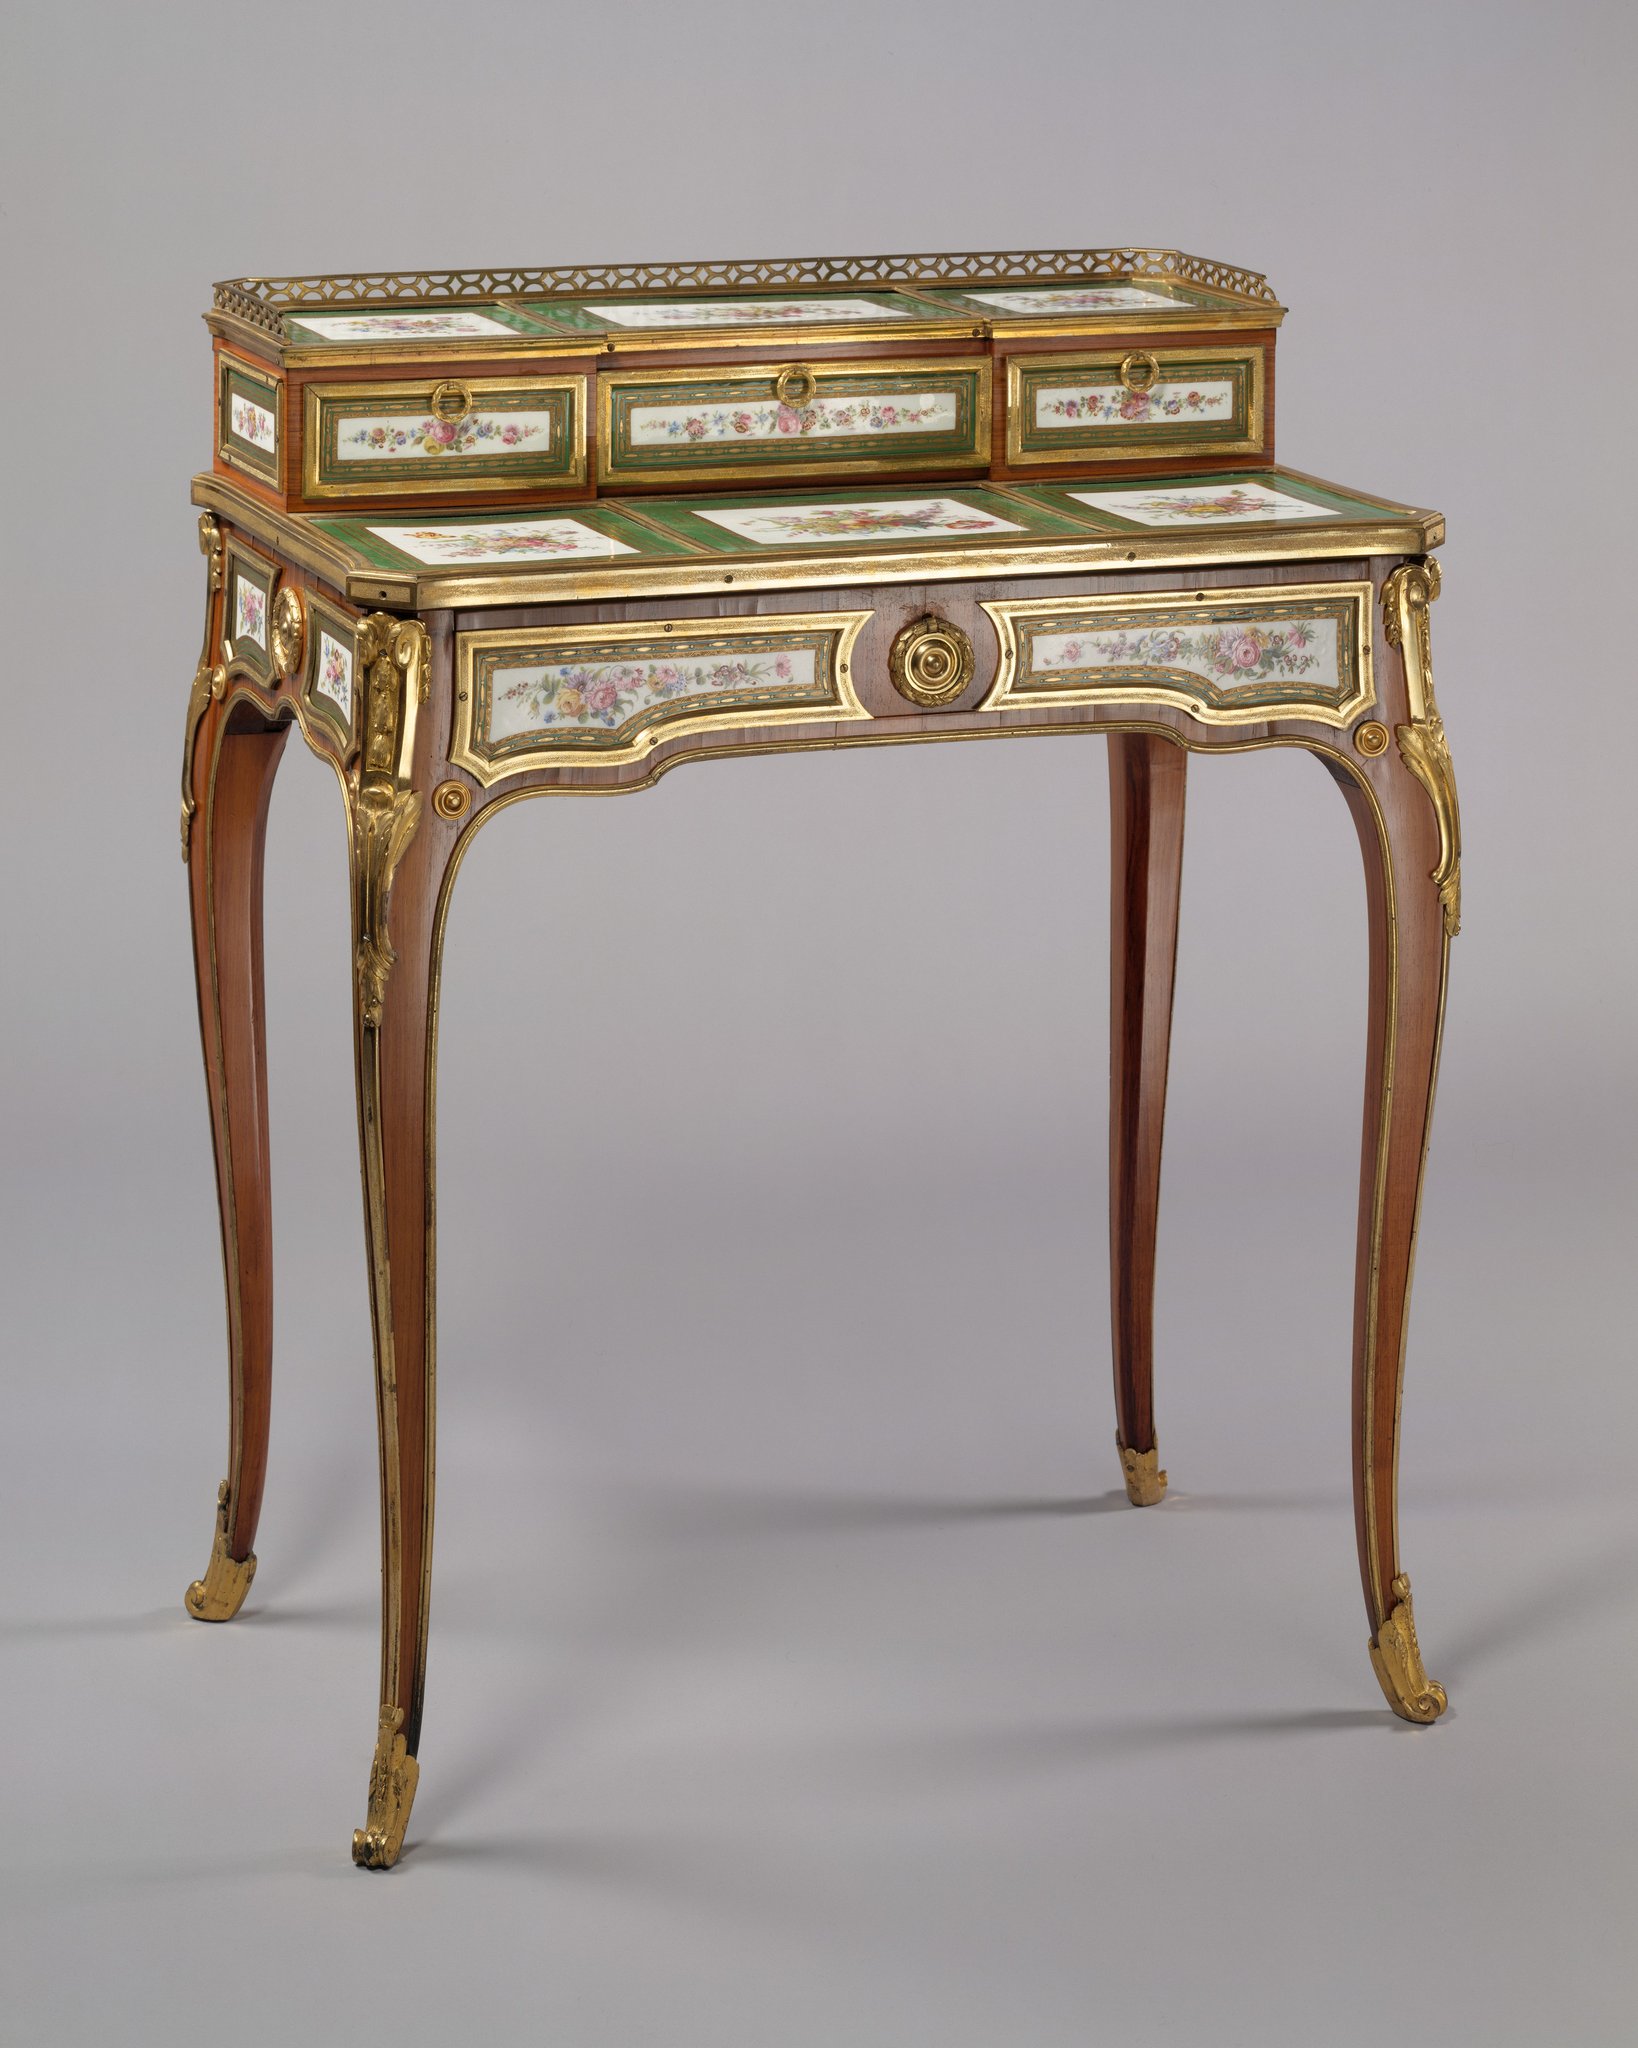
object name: desk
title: Desk (bonheur du jour)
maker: martin carlin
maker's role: maker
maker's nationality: french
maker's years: 1725-1785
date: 1770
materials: wood, gilt bronze, soft paste porcelain